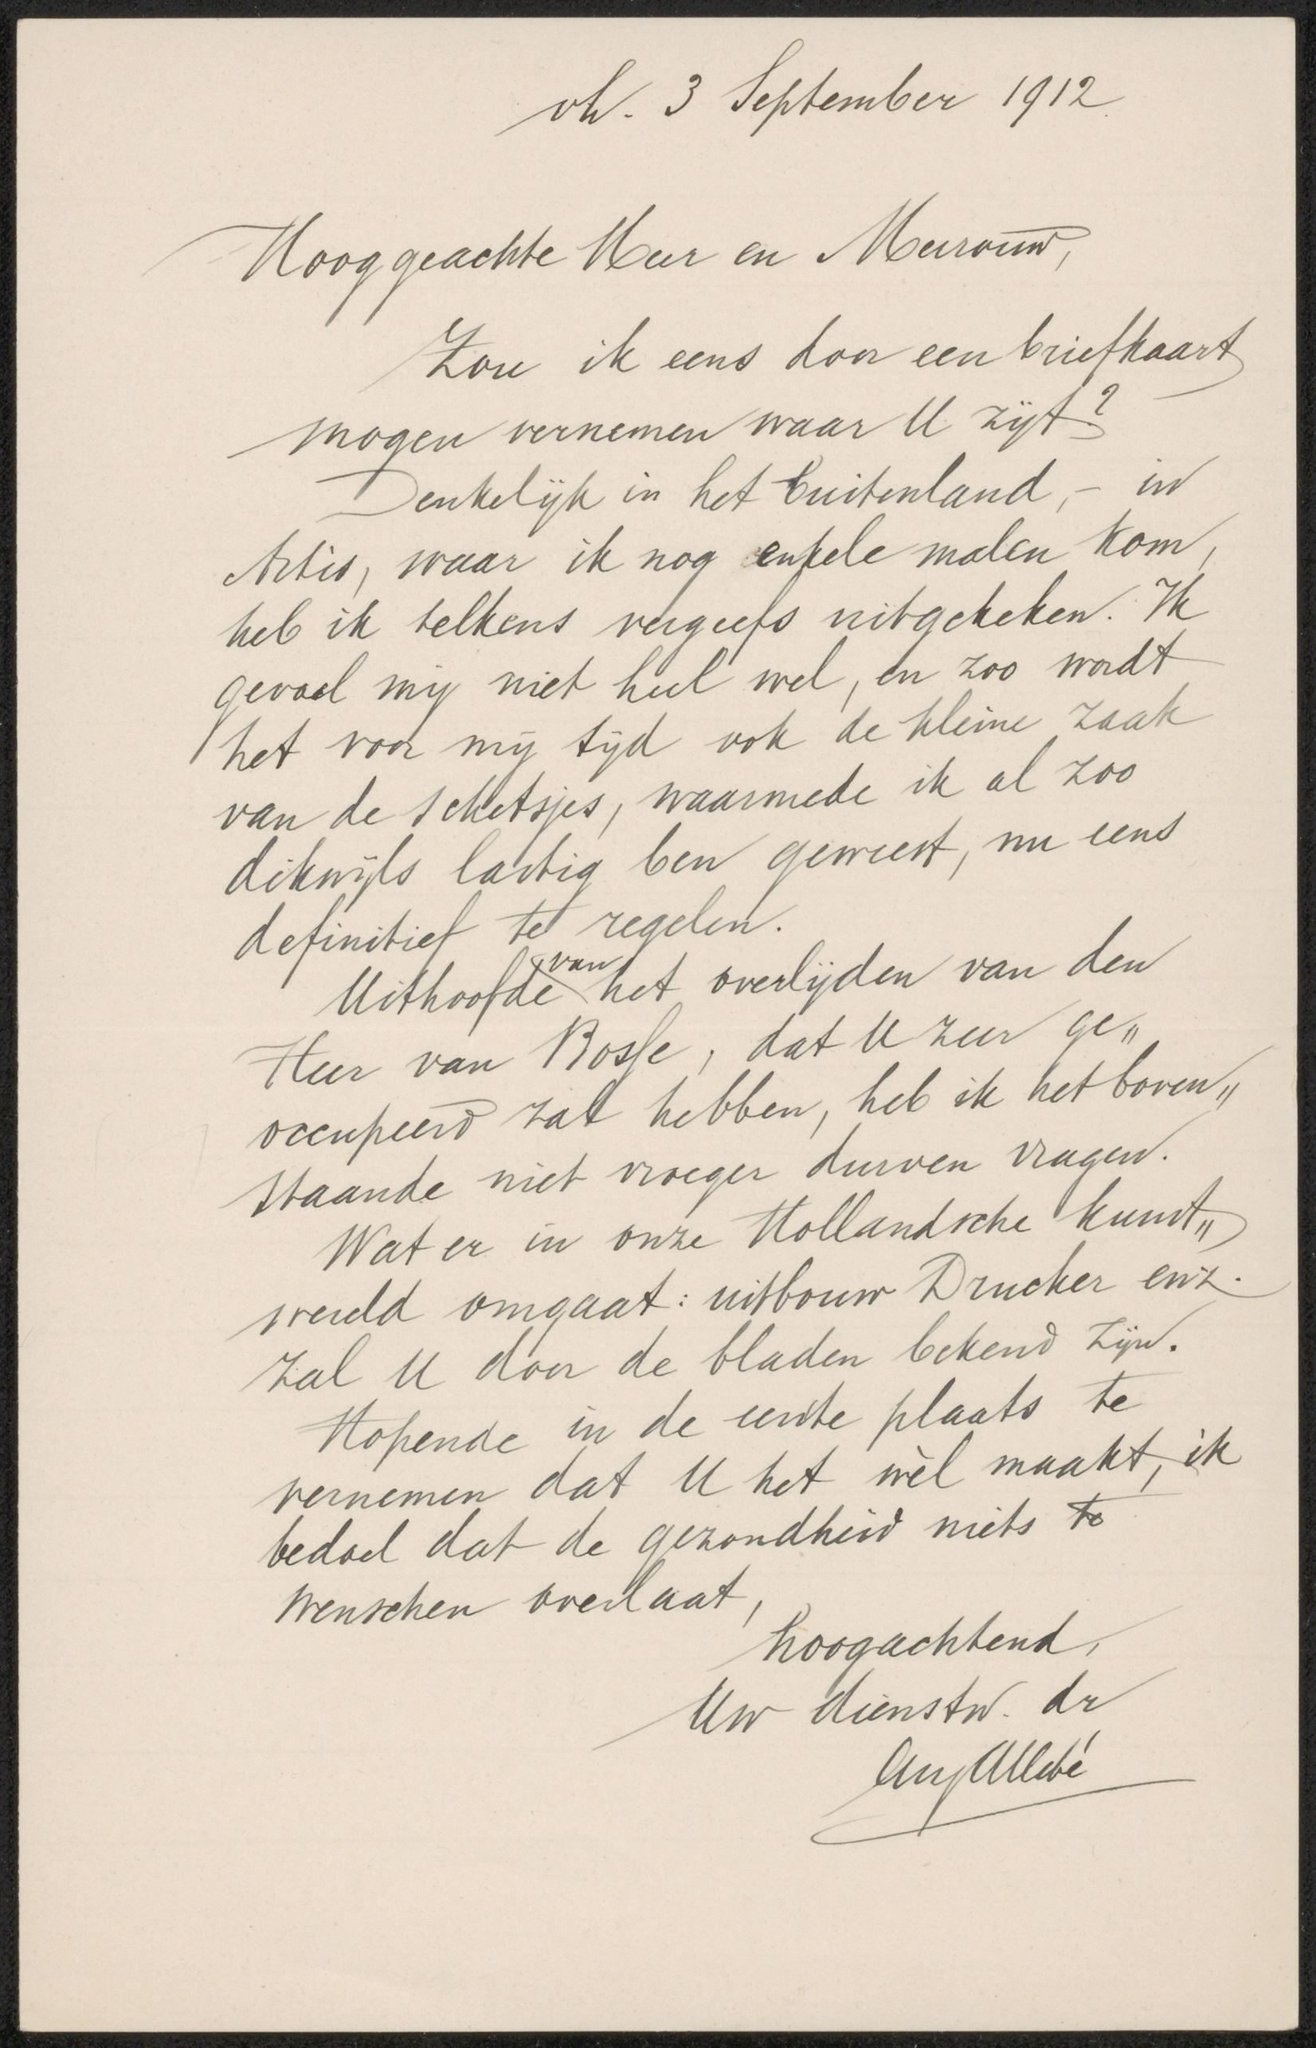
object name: letter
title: Brief aan Max Wilhelm Carl Weber en Anne Antoinette Weber-Van Bosse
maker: august allebé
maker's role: draughtsman, print maker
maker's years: 1838-1927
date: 1912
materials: ink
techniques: pen, writing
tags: anne antoinette weber-van bosse, rijksmuseum amsterdam, drawing, family life